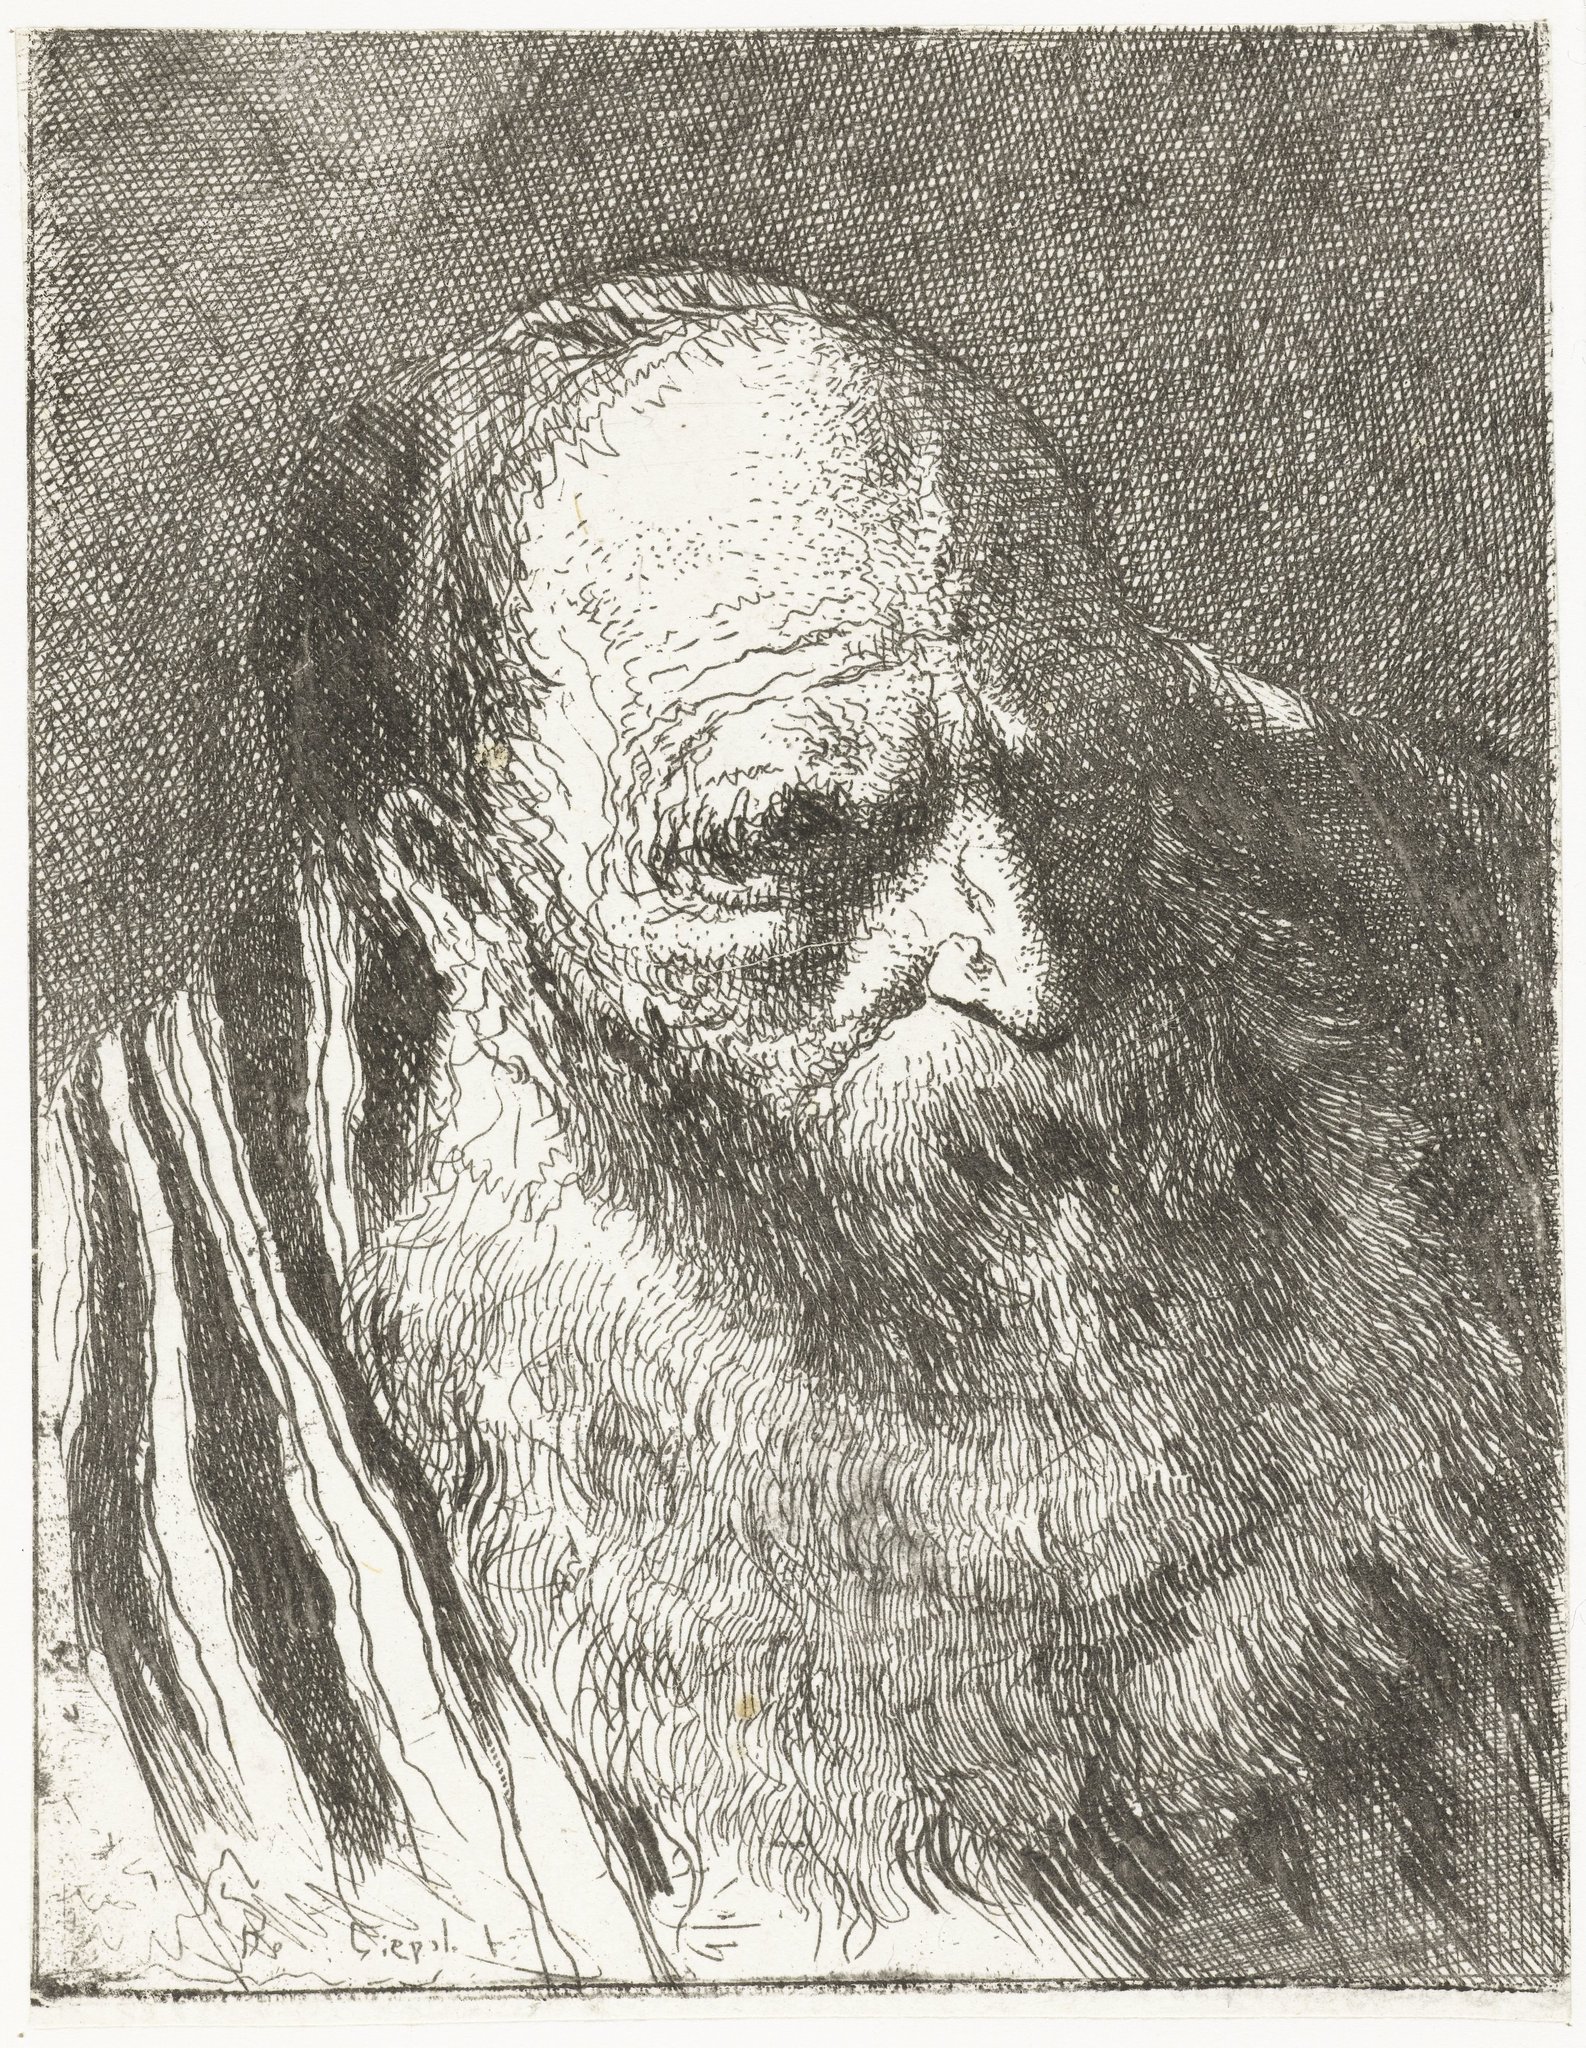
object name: print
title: Verzameling hoofden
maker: giovanni domenico tiepolo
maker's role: draughtsman, print maker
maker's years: 1727-1804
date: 1757-1758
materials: paper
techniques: etching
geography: venice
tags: person with big beard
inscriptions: collector's mark: Lugt 2228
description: Prent uit serie Verzameling hoofden (Raccolta di teste). Giovanni Domenico Tiepolo vervaardigde in de winter van 1757-1758 en in de periode van 1771-1774 deze hoofden naar schilderijen en tekeningen van Giovanni Battista Tiepolo. De eerste uitgave verscheen in 1774 in twee delen met elk dertig prenten. Deze prent werd in de tweede staat met serienummer 23 opgenomen in deel 2.